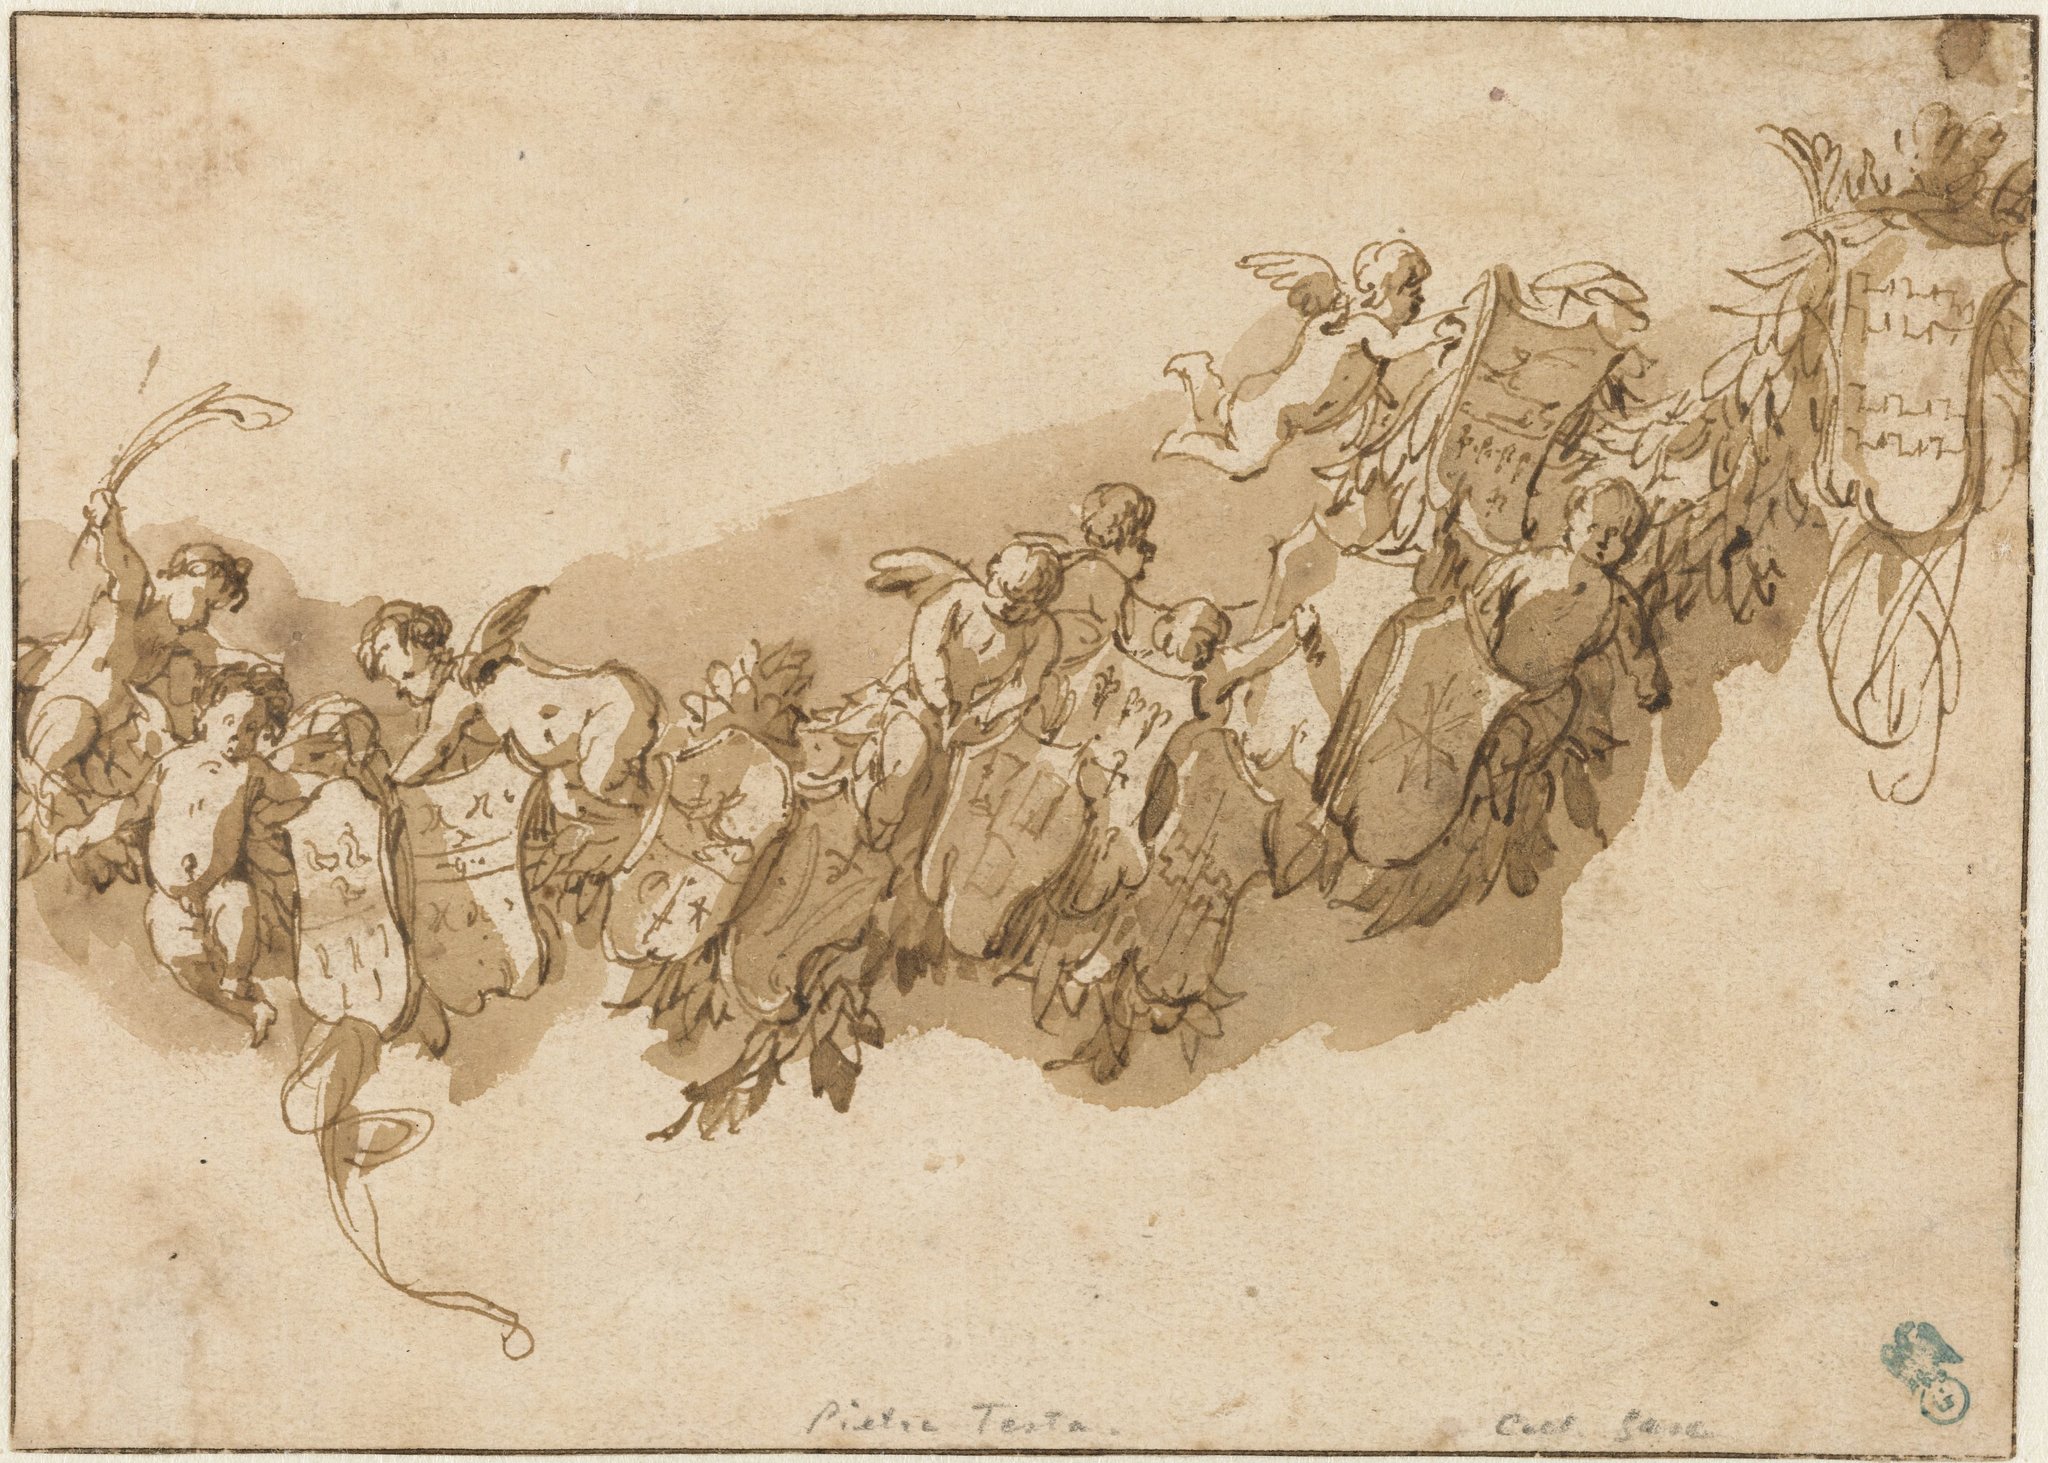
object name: drawing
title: Heraldische guirlande omgeven door engelen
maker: nicolaes pietersz berchem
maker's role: draughtsman, print maker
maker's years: 1620-1683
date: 1630-1683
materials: ink, paper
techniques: brush, pen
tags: ornament ~ festoon, garland, cupids: 'amores', 'amoretti', 'putti', armorial bearing, heraldry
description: Heraldische guirlande, afhangend van een wapenschild en omgeven door gevleugelde engelen die schilden vasthouden.